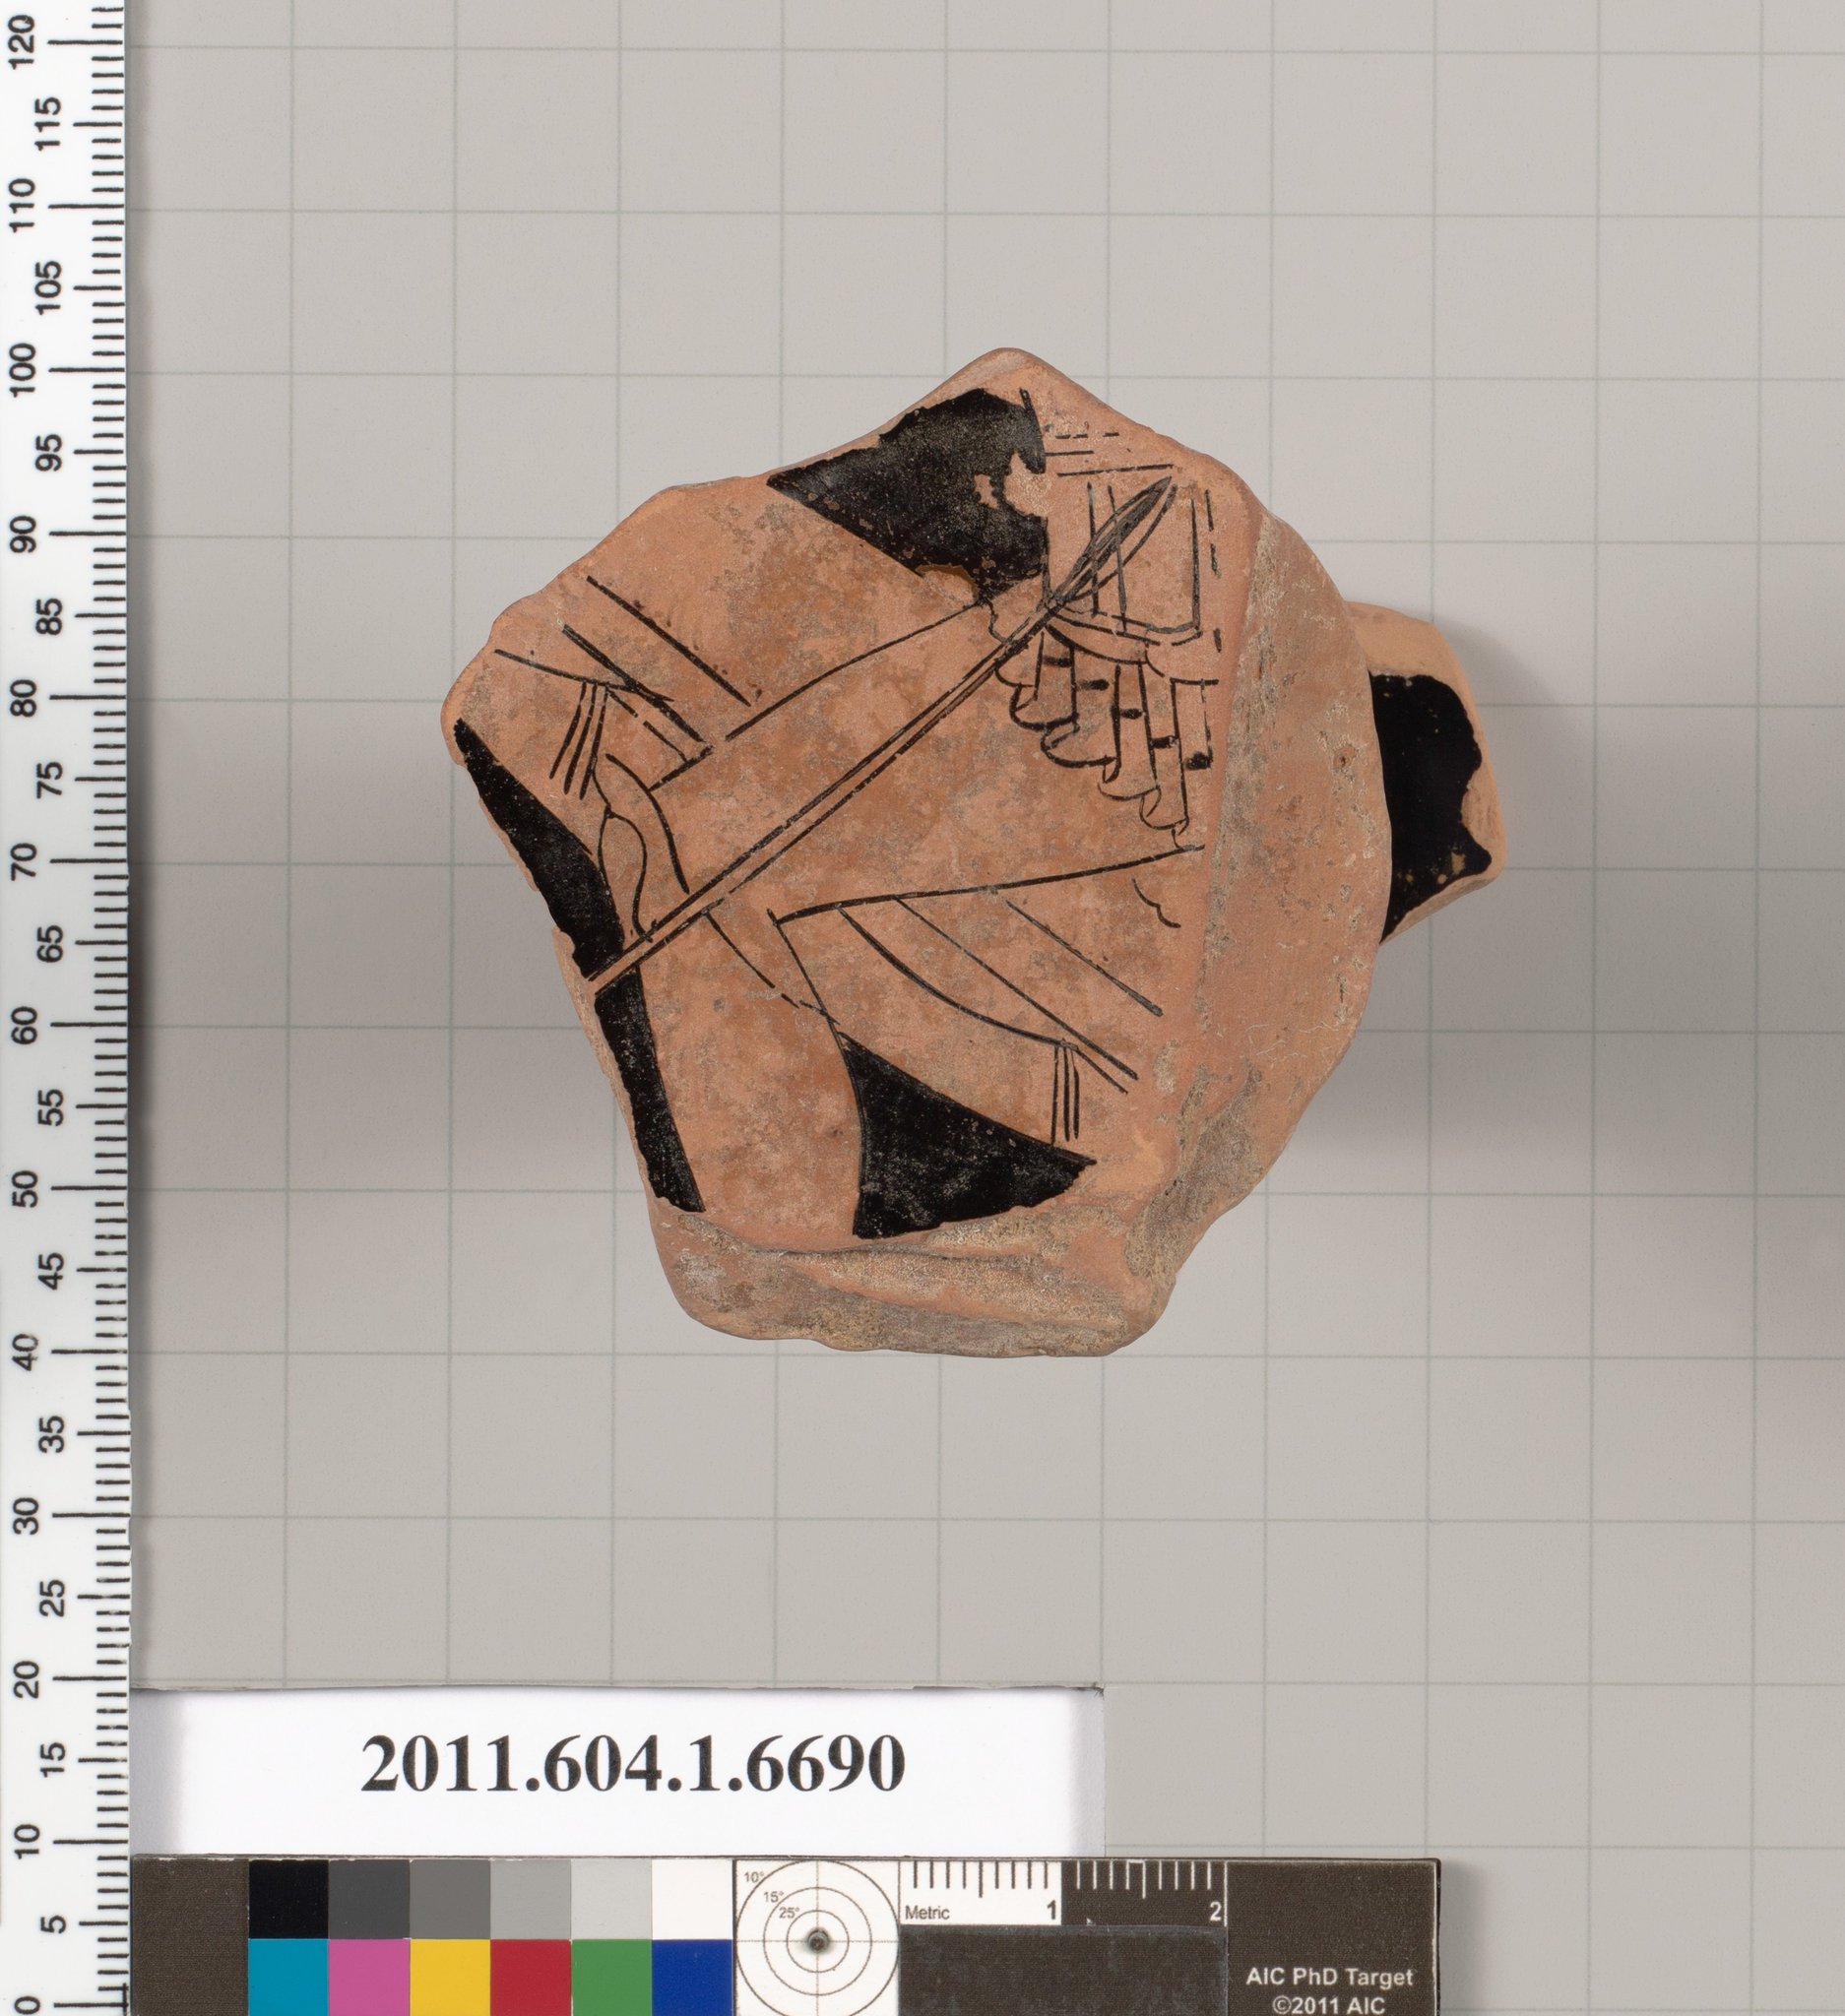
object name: kylix fragment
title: Terracotta fragment of a kylix (drinking cup)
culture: greek, attic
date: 490-470 BCE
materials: terracotta